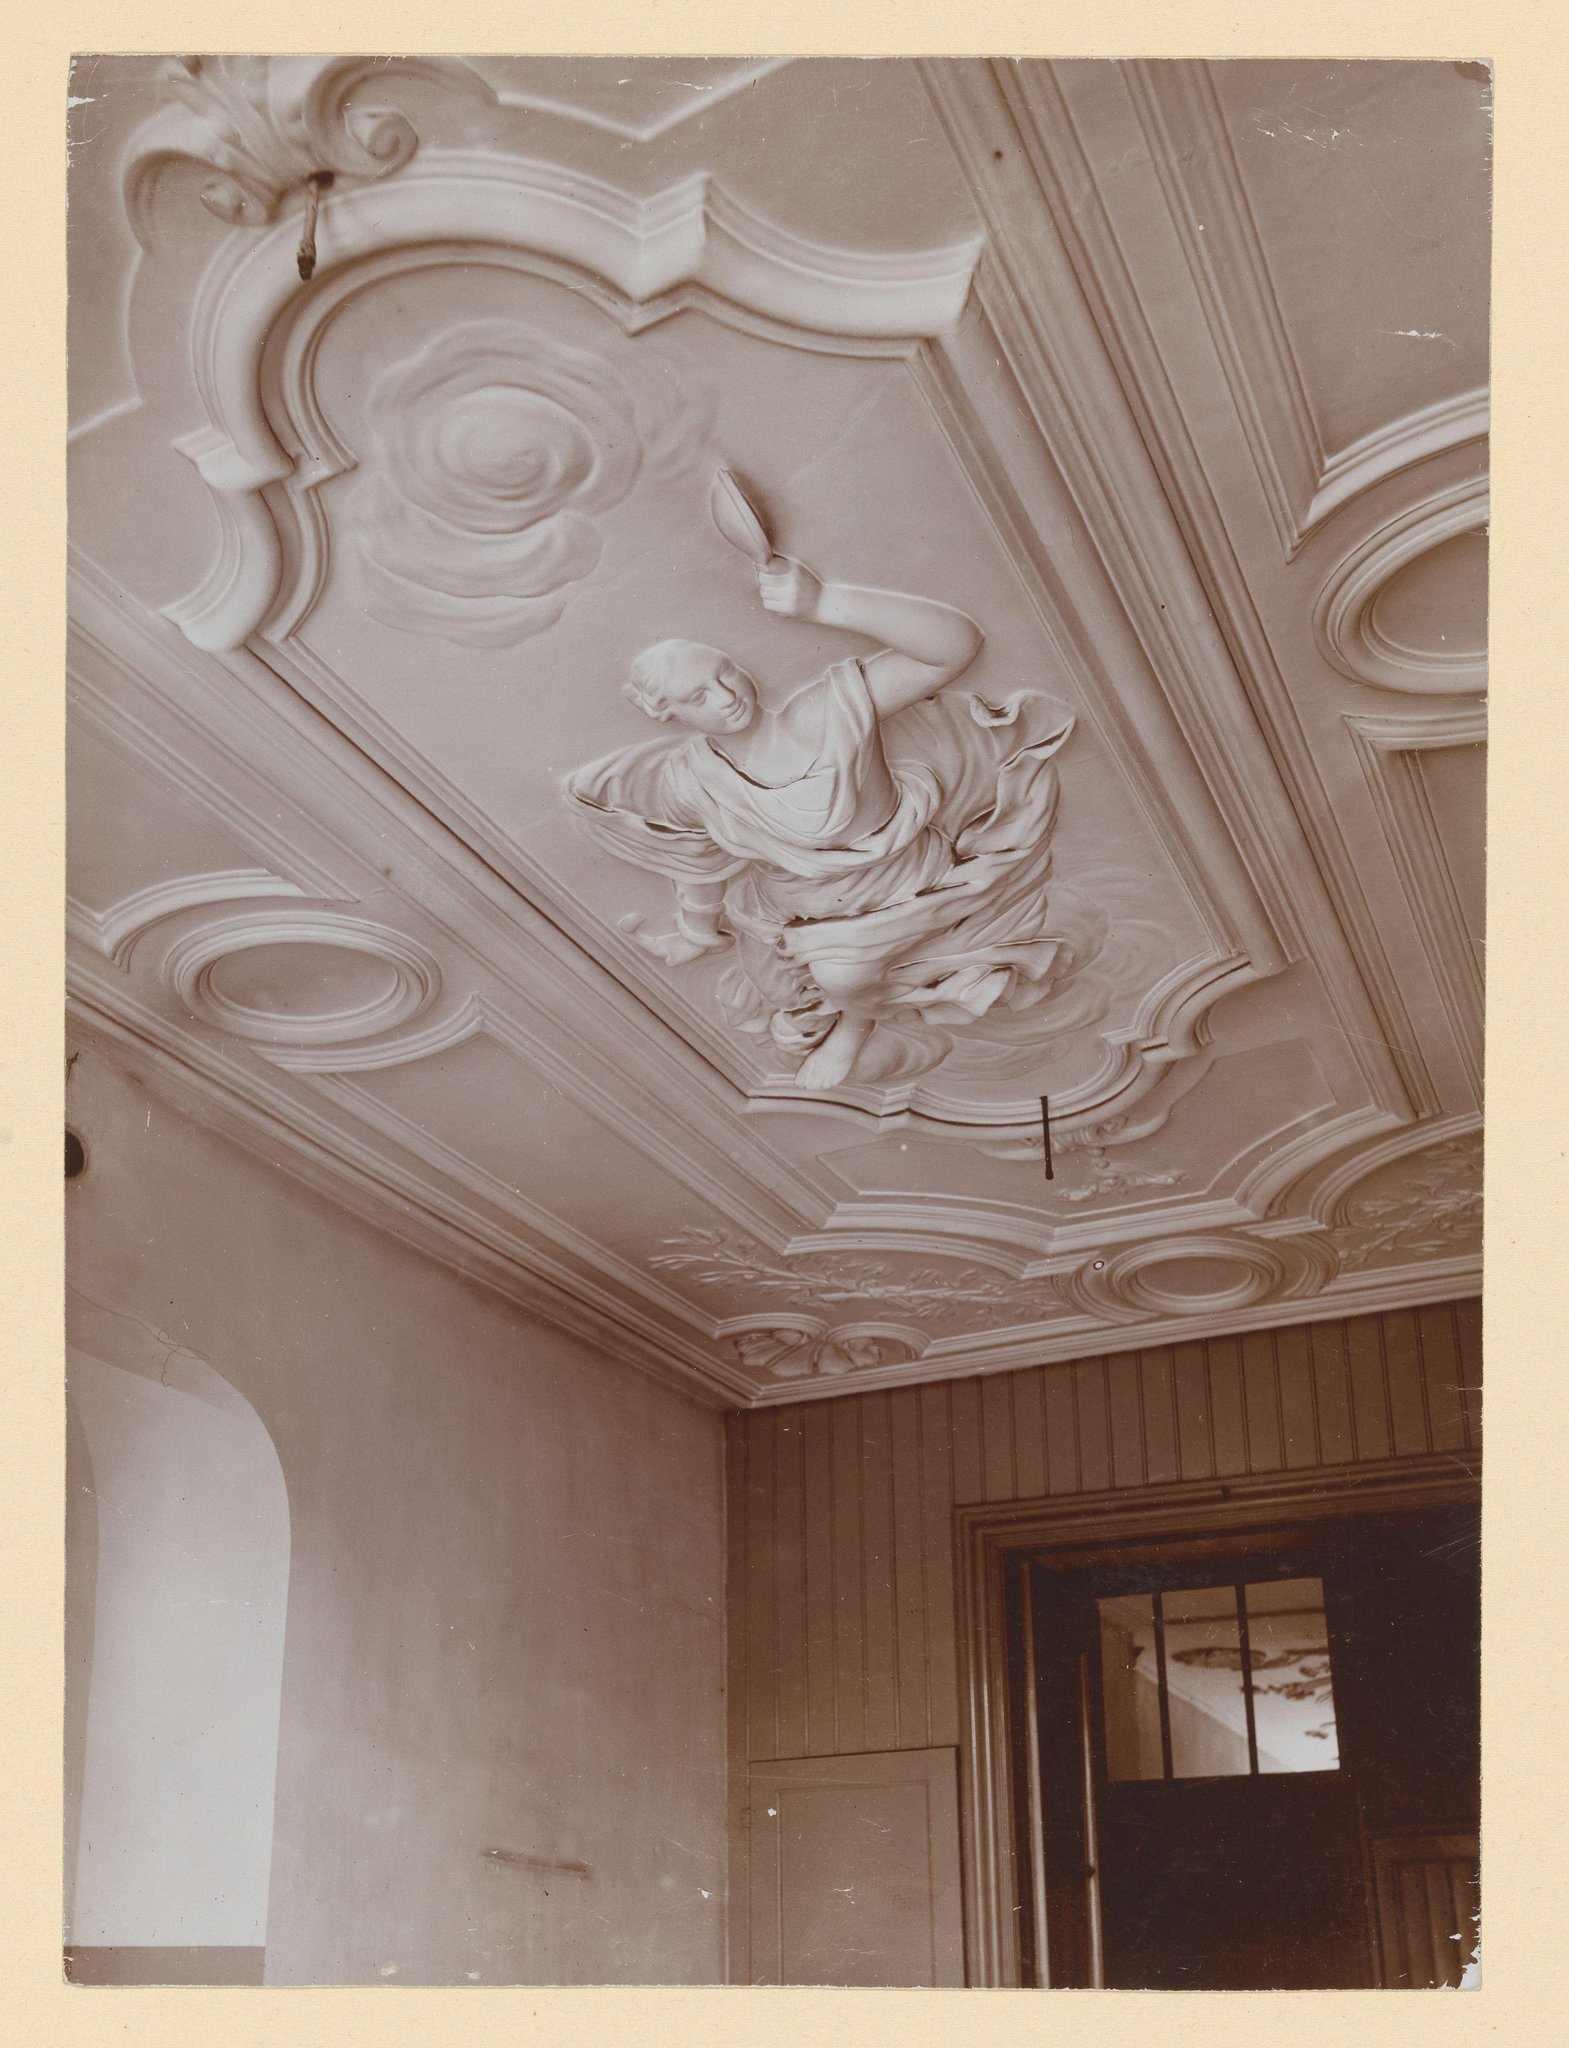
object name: photograph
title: Plafond met stucwerk in het Paushuize te Utrecht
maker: anoniem (monumentenzorg)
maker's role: fotograaf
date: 1911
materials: cardboard, photographic support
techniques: collodion silver print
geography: paushuize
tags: (decorated) ceiling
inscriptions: annotation: ‘Plafond in voorkamer huis Paus Adriaan Oudegracht 97 Utrecht Jan 1911’